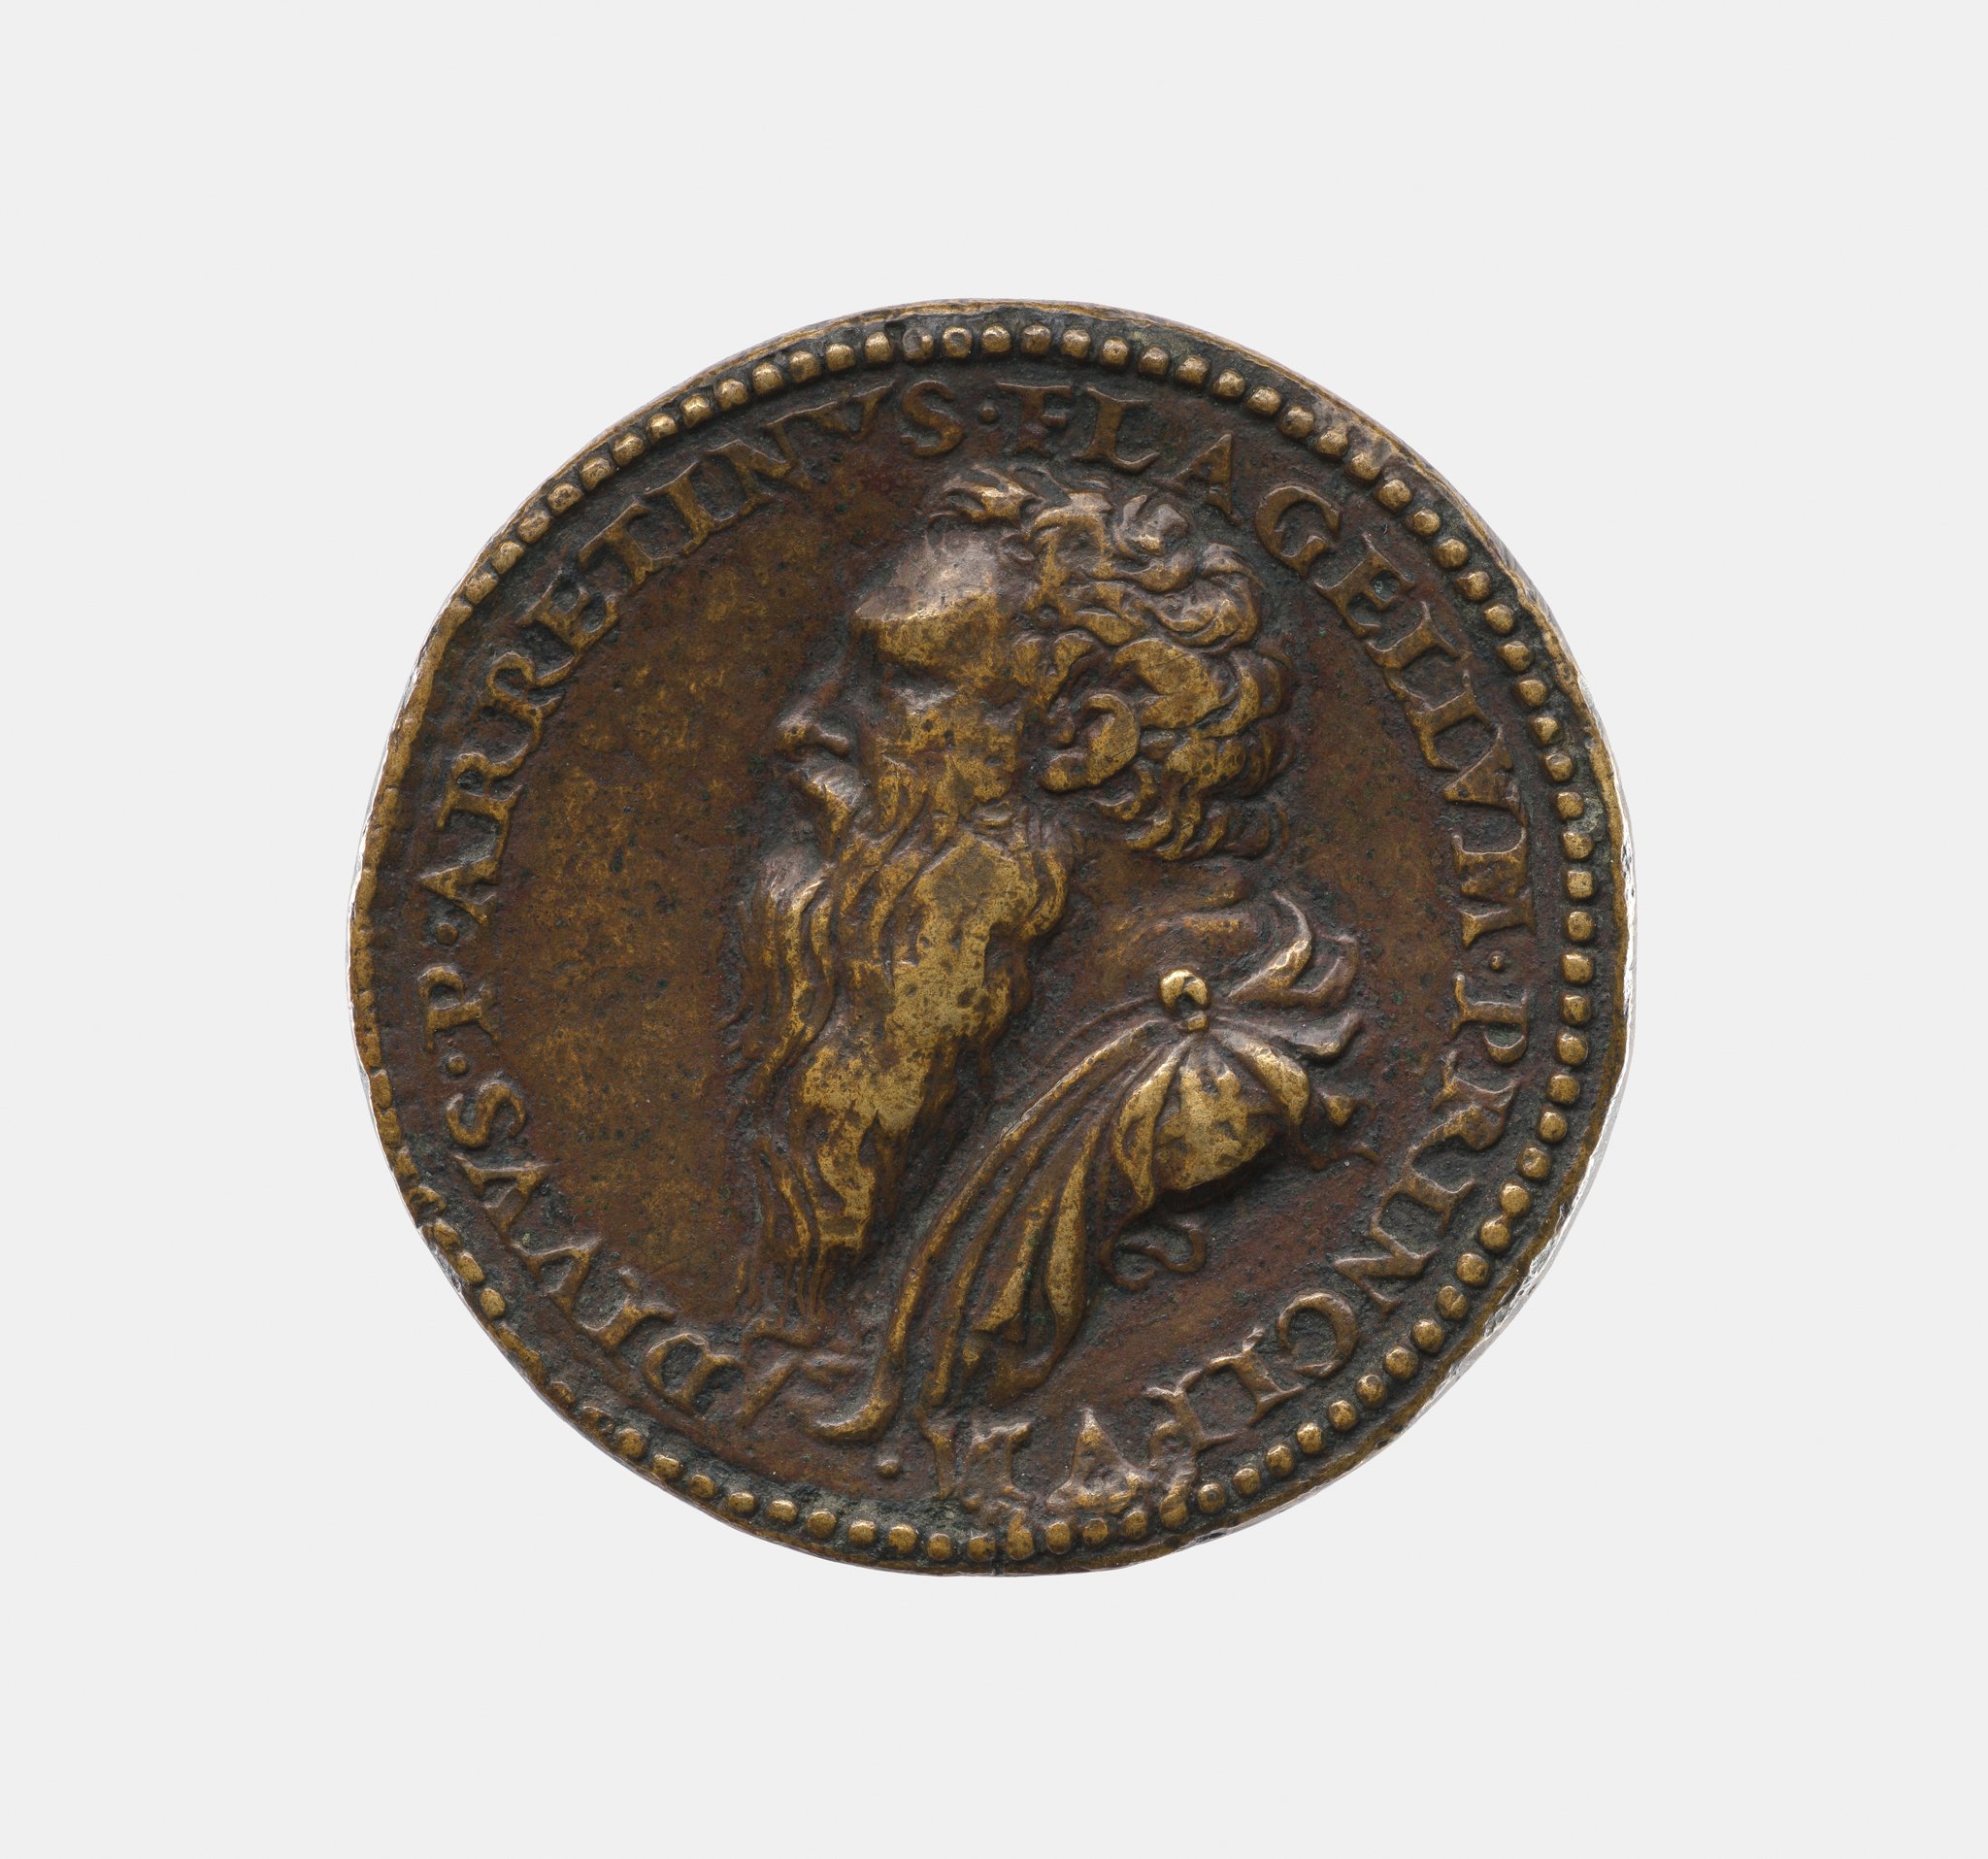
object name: medal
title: Pietro Bacci Aretino (1492–1556)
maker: leone leoni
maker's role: artist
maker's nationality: italian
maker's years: 1504-1590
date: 1537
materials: bronze